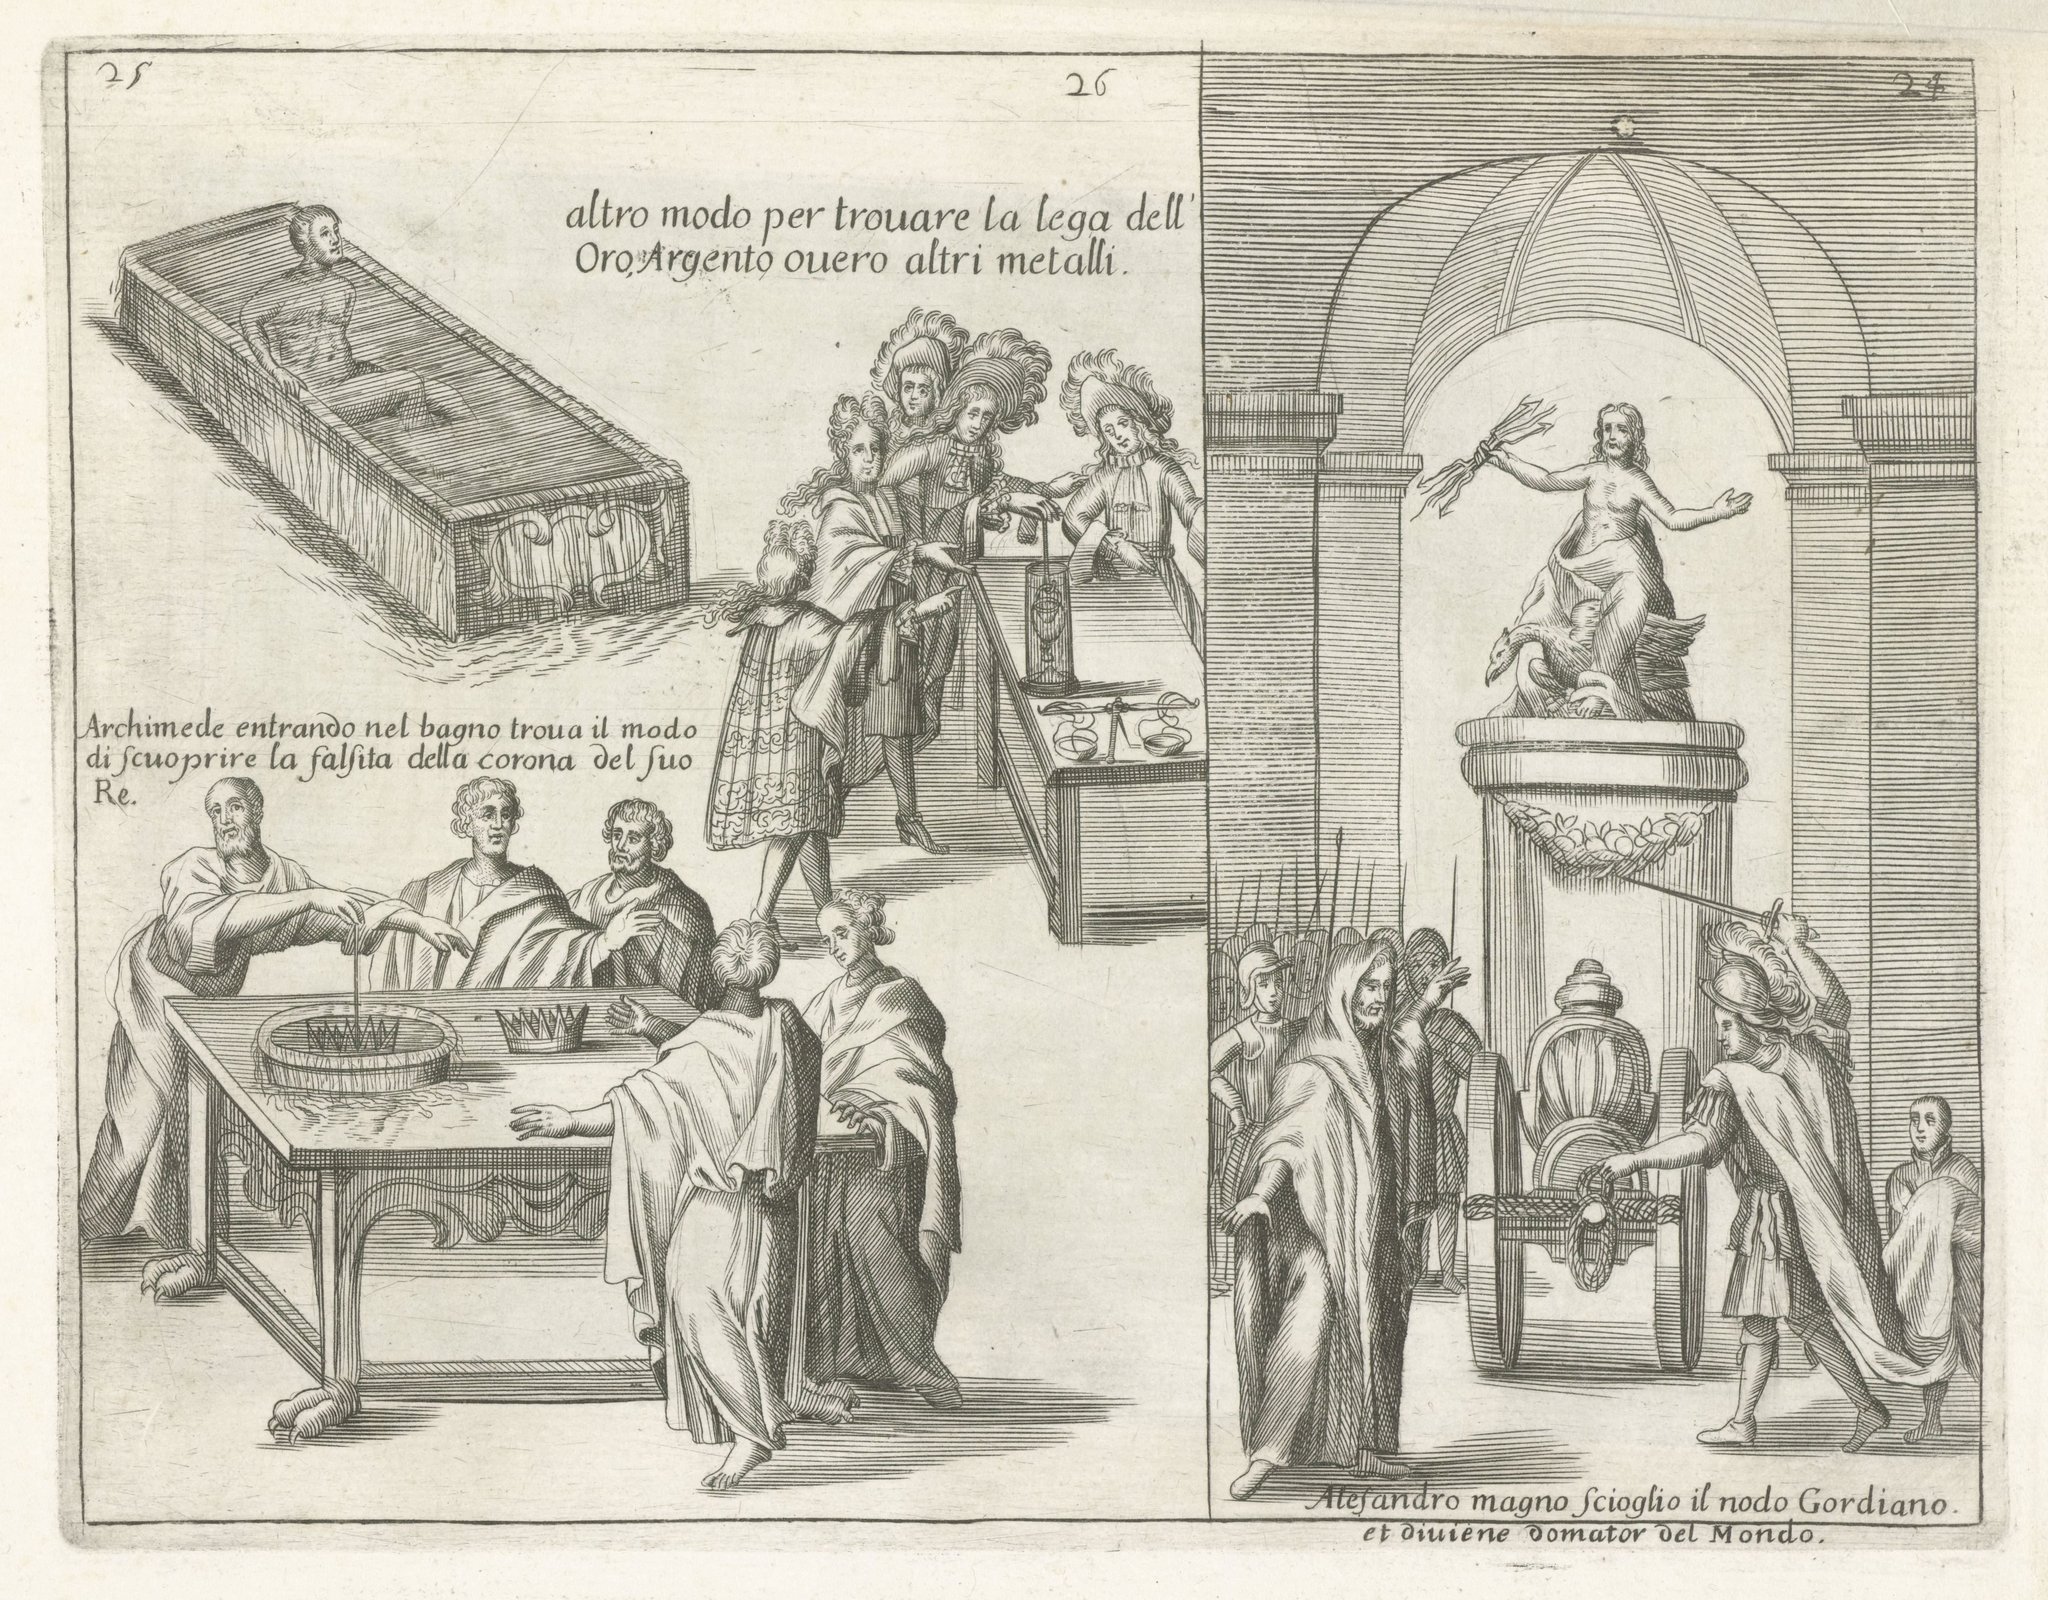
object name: print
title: Racolta di varii segreti come si vedono nelle segventi figure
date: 1696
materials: paper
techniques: etching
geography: rome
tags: alexander cuts the gordian knot with his sword, weighing gold or money (+ variant), (story of) archimedes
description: Vier figuren rond een tafel met daarop een instrument om de echtheid van goud, zilver en andere metalen te testen. Linksboven Archimedes in zijn bad. Linksonder Archimedes met mannen rond een tafel. Door zijn kroon in een bad te leggen, ontdekt hij dat deze niet van echt goud gemaakt is. Rechts Alexander de Grote, die de gordiaanse knoop doorhakt met zijn zwaard.